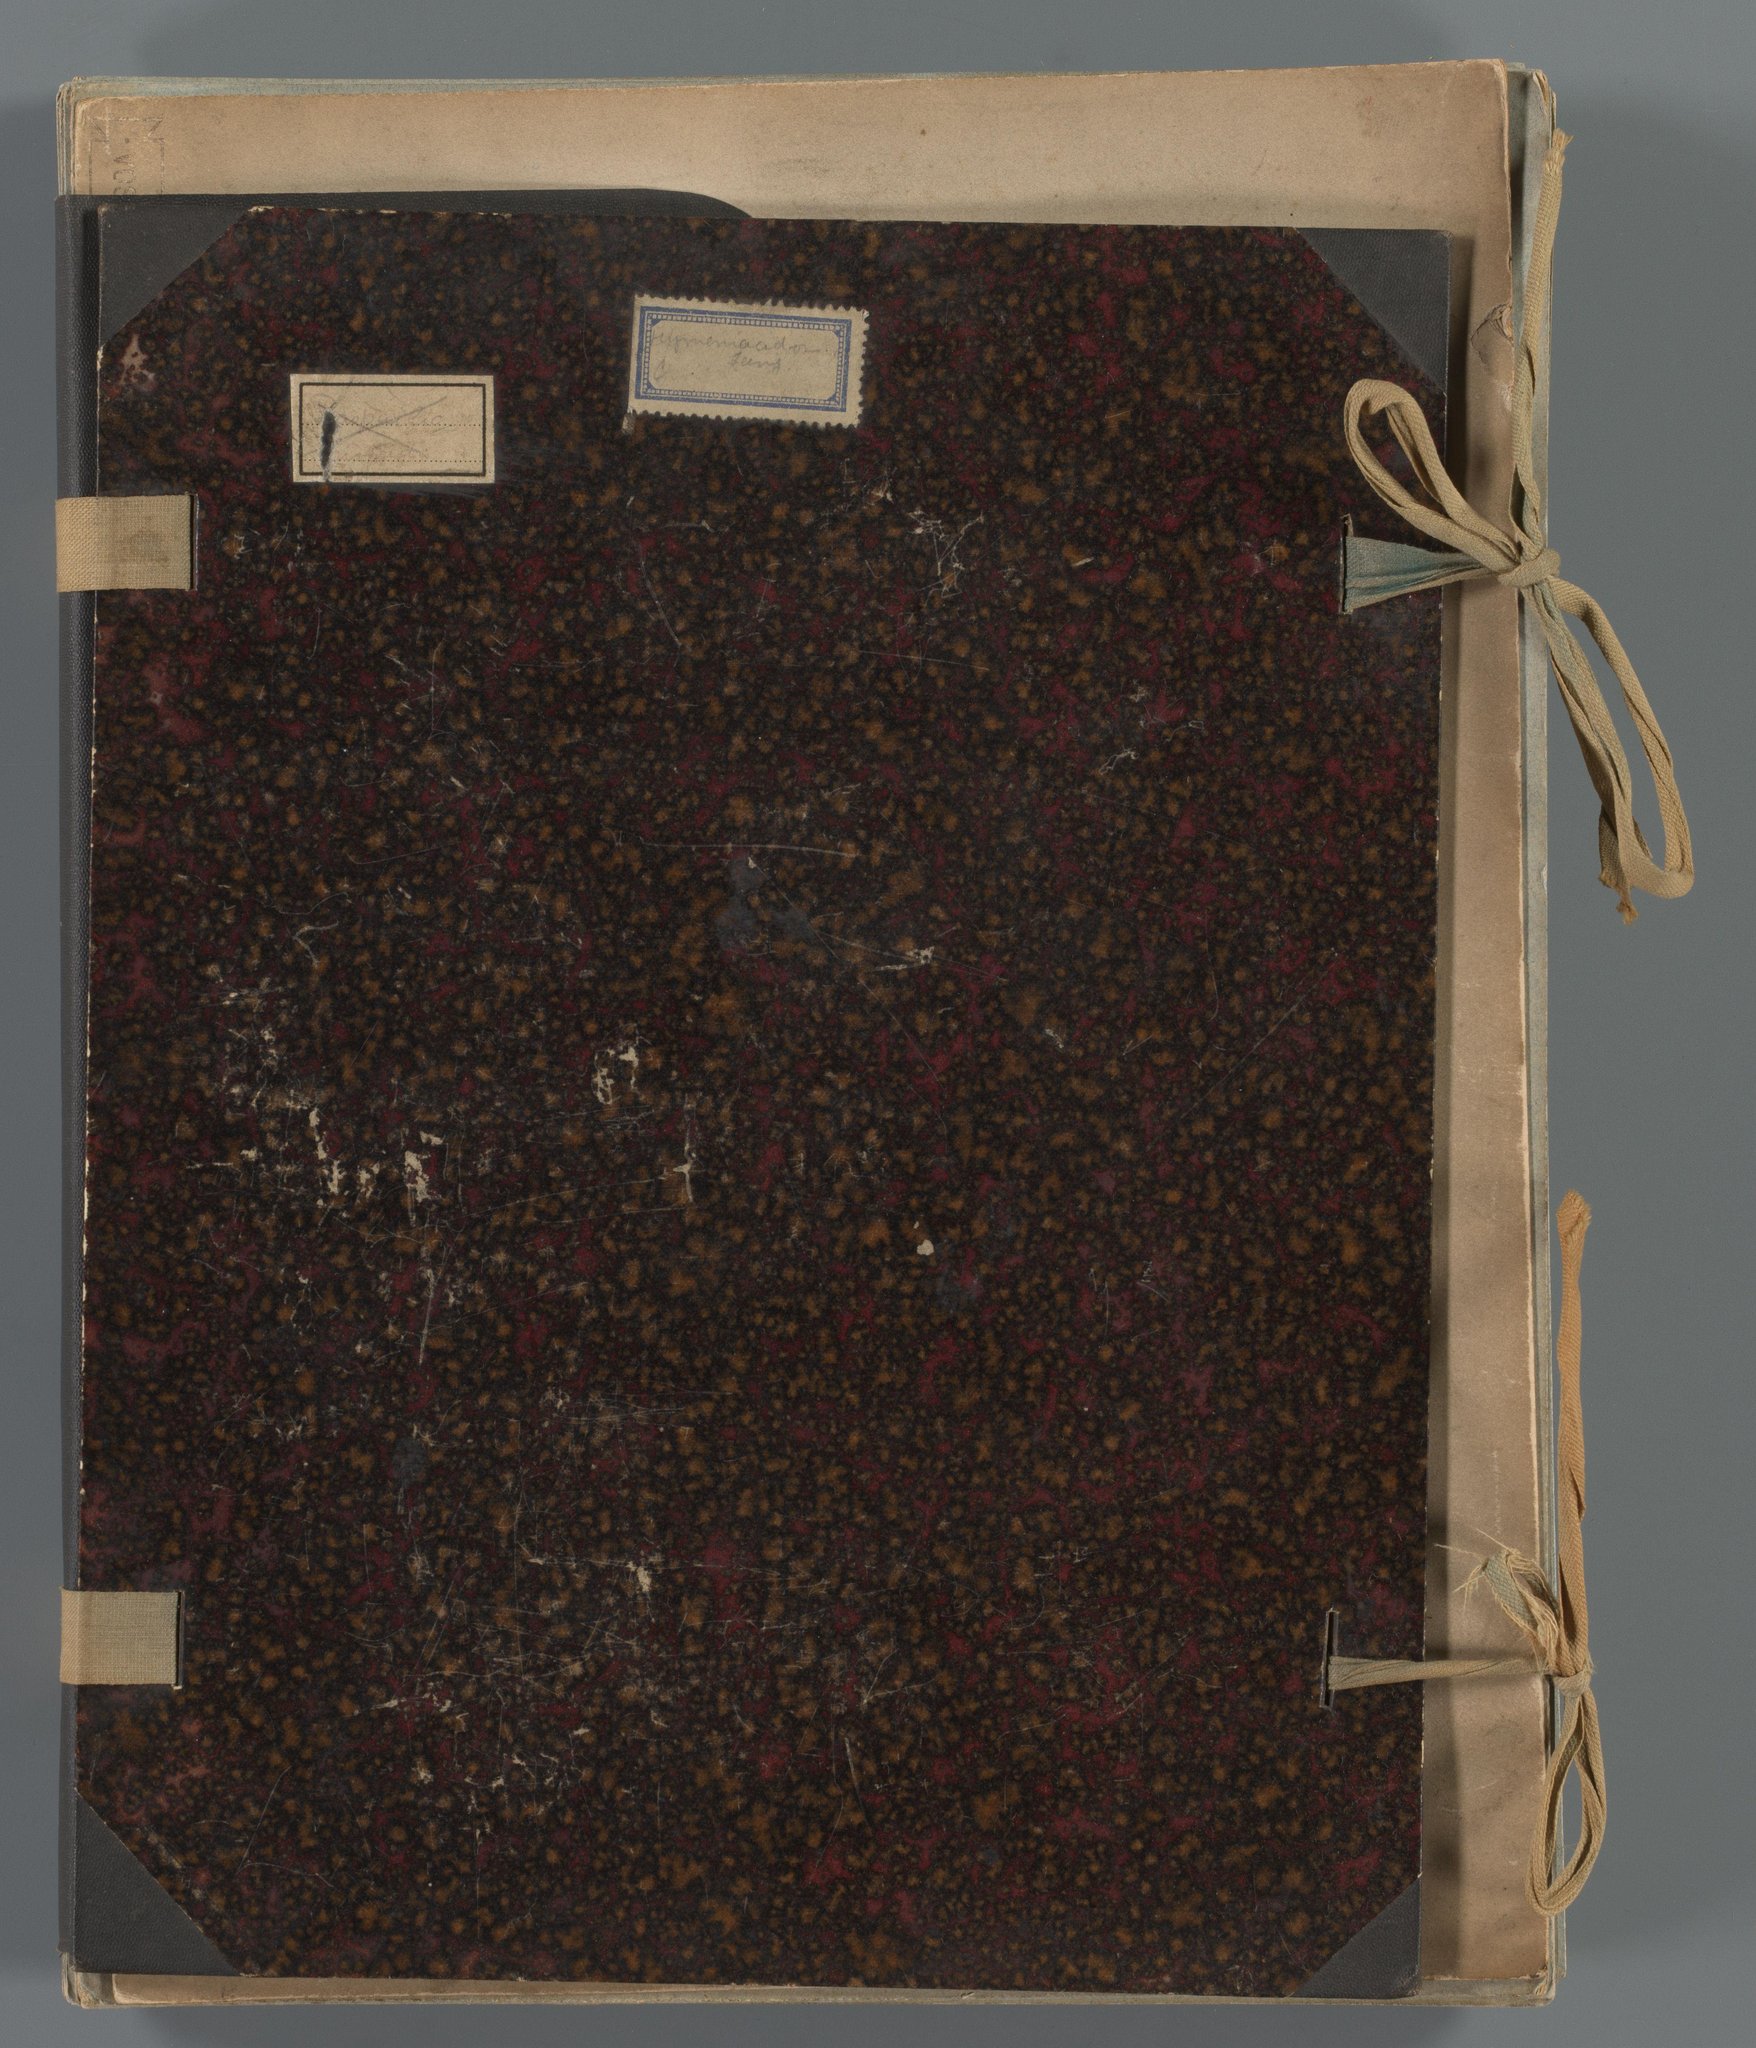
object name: wrapper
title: Omslag voor 39 foto's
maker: Anonymous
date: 1873-1900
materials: cardboard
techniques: albumen print, etching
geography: italy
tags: laboratory, zoology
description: Omslag met 39 foto's opgezet op karton. Afgebeeld is het Zoölogisch Station en omgeving in Napels.